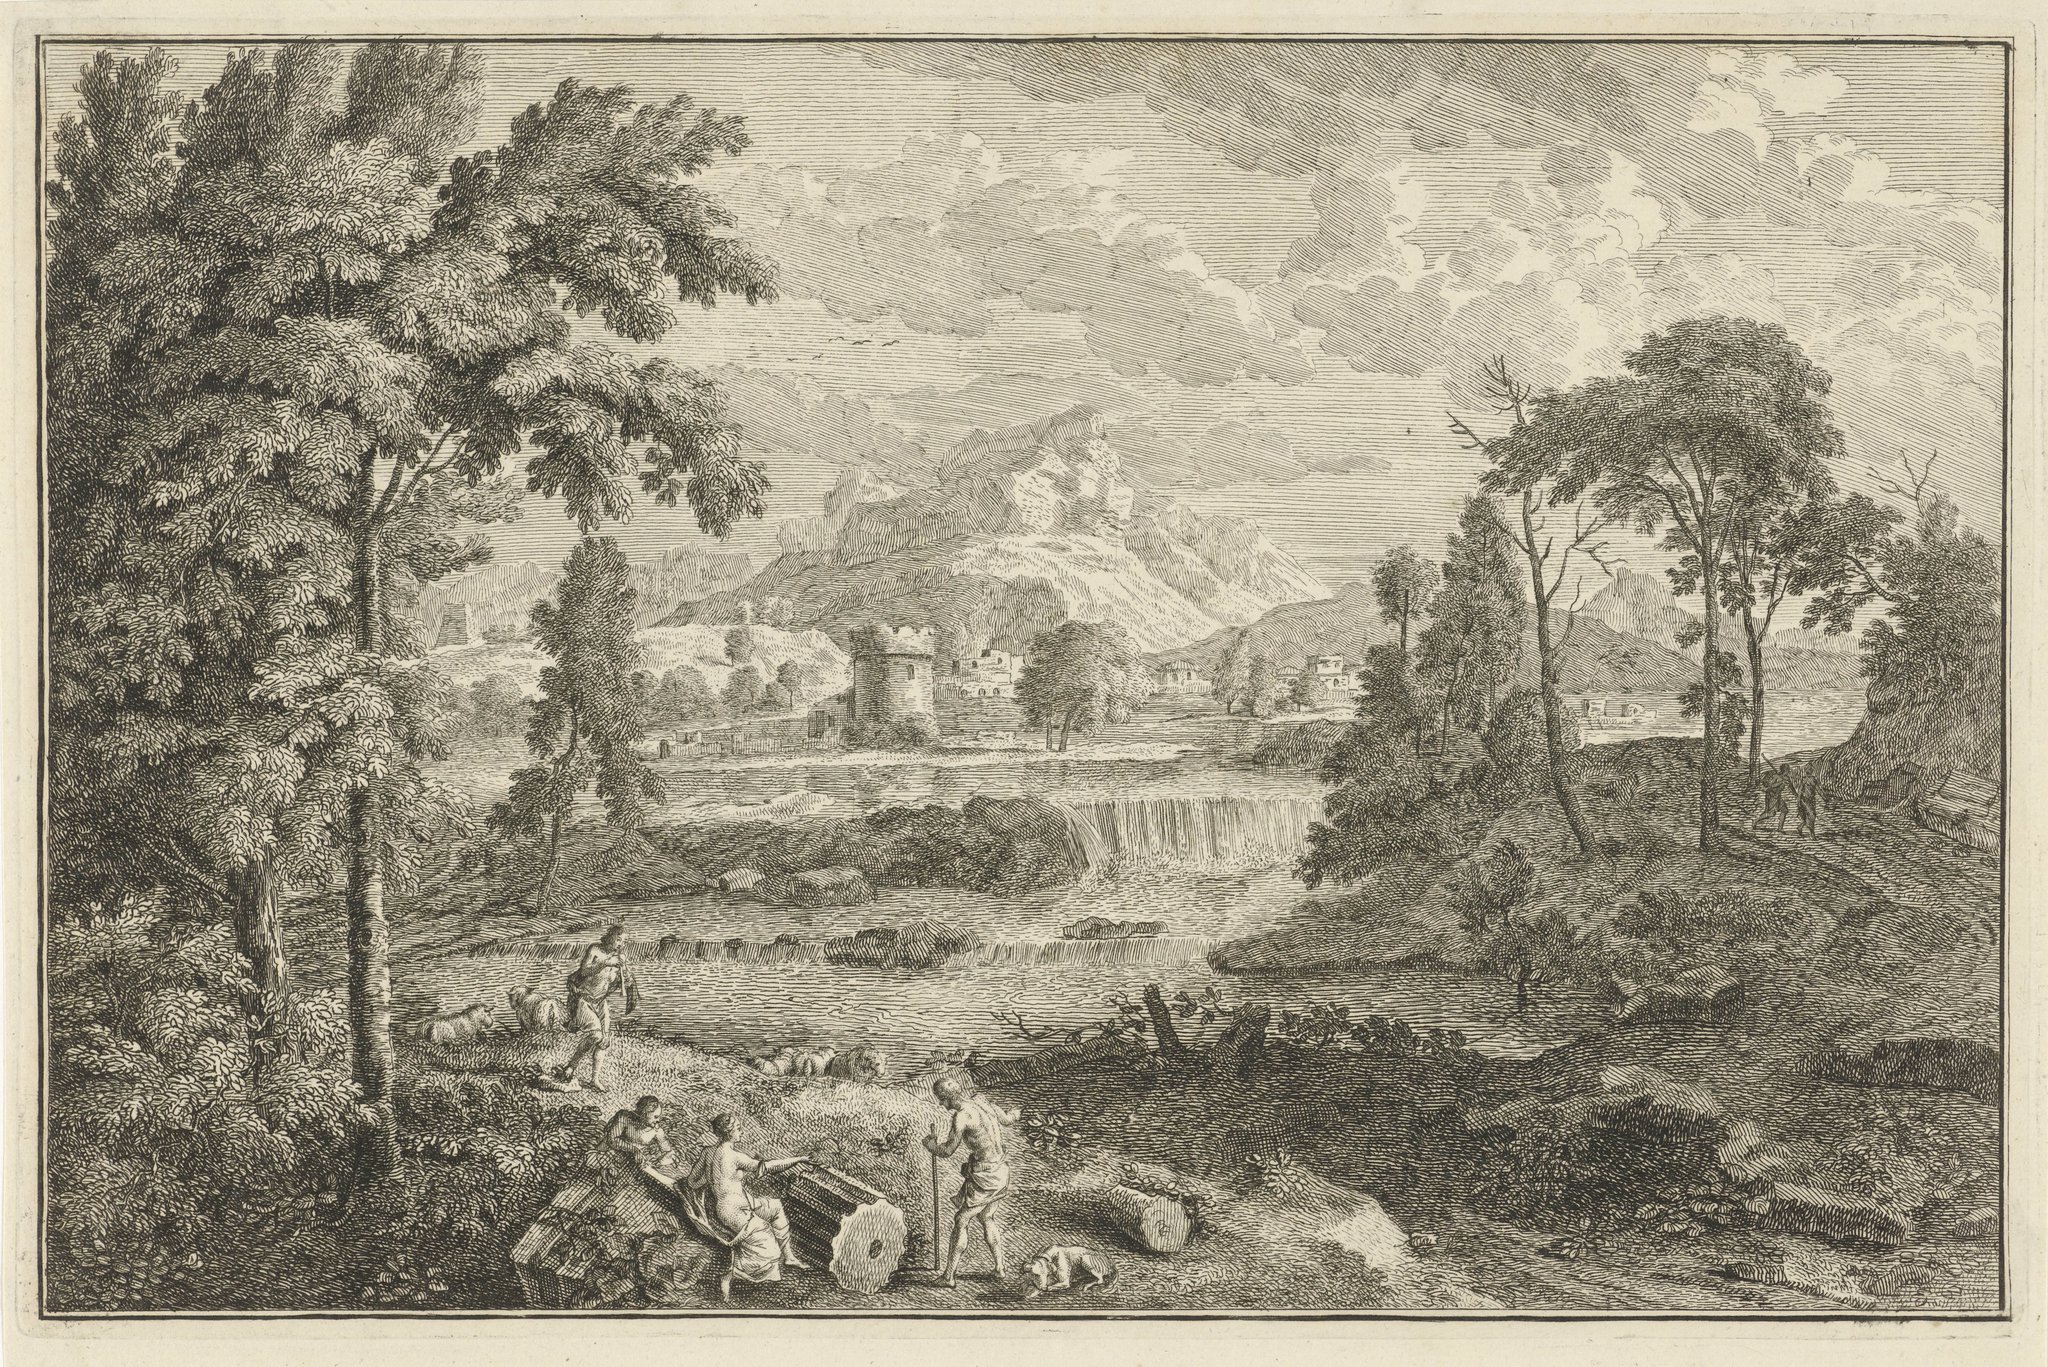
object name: print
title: Italiaanse en Duitse landschappen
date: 1710-1747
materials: paper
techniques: etching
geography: amsterdam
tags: herding, herdsman, herdswoman, shepherd, shepherdess, cowherd, etc., ruin of a building ~ architecture, landscapes with waters, waterscapes, seascapes (in the temperate zone)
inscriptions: collector's mark: Lugt 240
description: Arcadisch rivierlandschap met herders, op de voorgrond twee figuren bij brokstukken van een tempel. De prent maakt deel uit van een 40-delige serie prenten met voorstellingen van Italiaanse en Duitse landschappen.